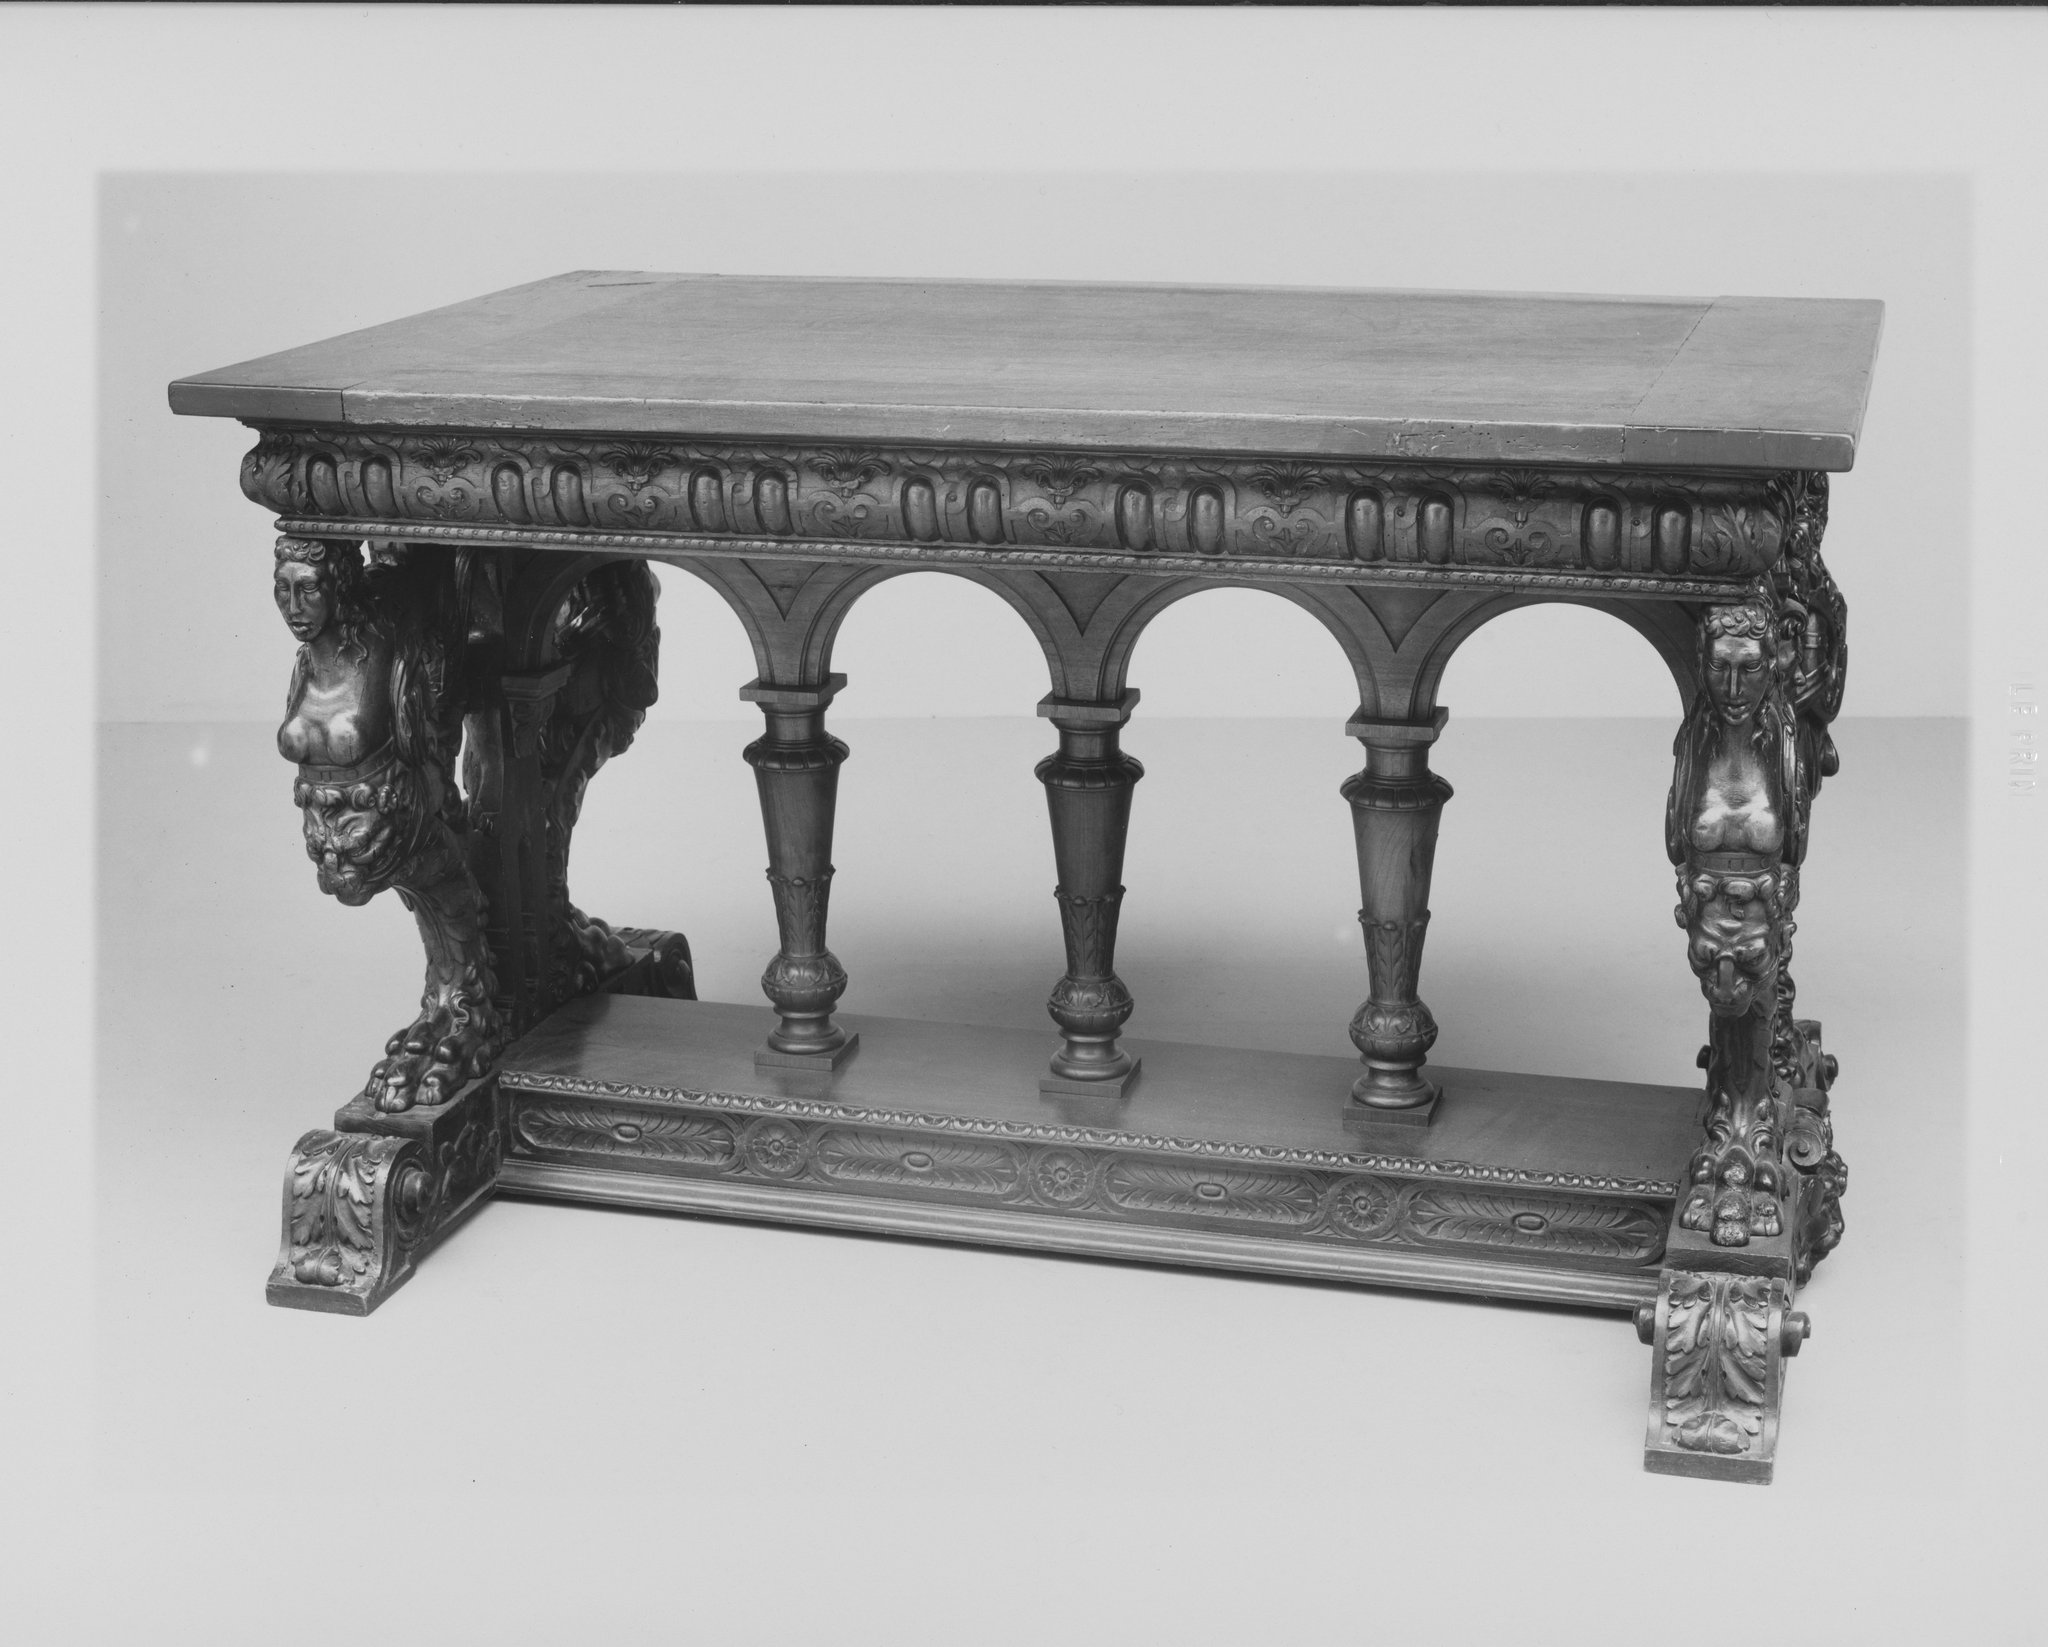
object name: table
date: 1801-1900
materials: wood